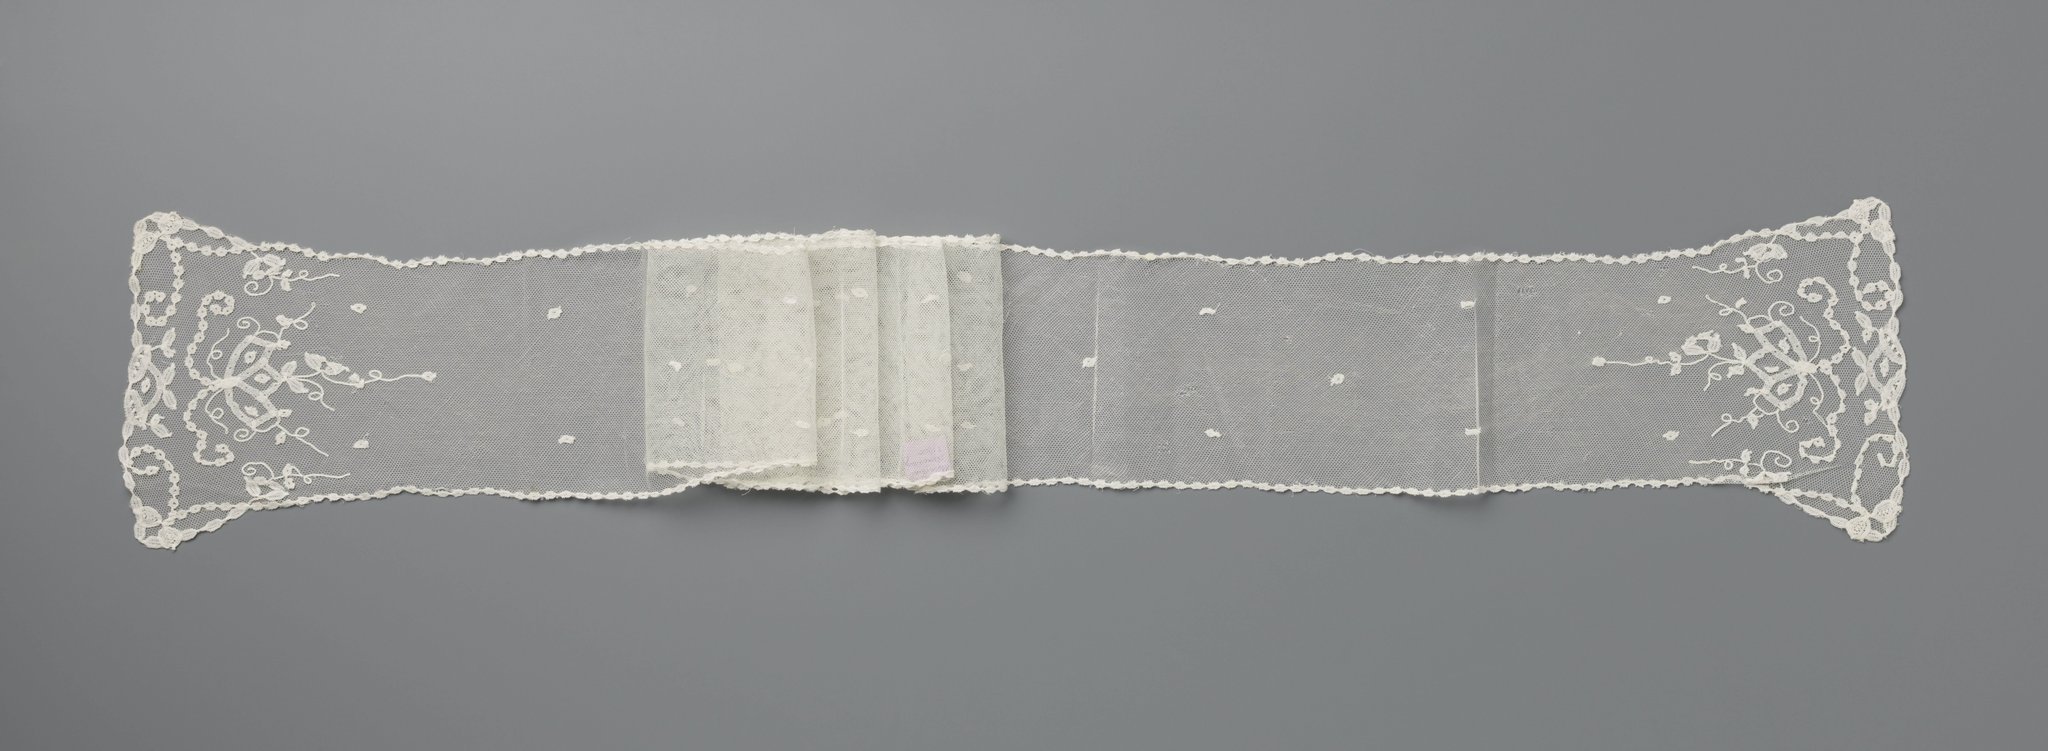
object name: womenswear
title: Das van applicatiekant met een waterlelie aan elk uiteinde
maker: Anonymous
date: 1890-1910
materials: lace, fiber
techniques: lace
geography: europe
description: Das van naturelkleurige applicatiekant: kloskant geappliceerd op machinale tule. Langgerekt rechthoekig model. Strooipatroon van weinig ovale blaadjes. De uiteinden zijn versierd met een waterlelie-achtige bloem, gemaakt met een geklost lint dat de contouren van driehoekige bloembladeren vormt. Enkele bladeren en dunne omkrullende slingers omringen deze bloem. De gekloste motieven zijn gemaakt in linnenslag met uitsparingen en deels voorzien van contourlijnen en picots. De schulpenrand langs de zijden komt voort uit een aaneenschakeling van ovaaltjes die rond de iets verbrede uiteinden een klein beetje groter zijn.